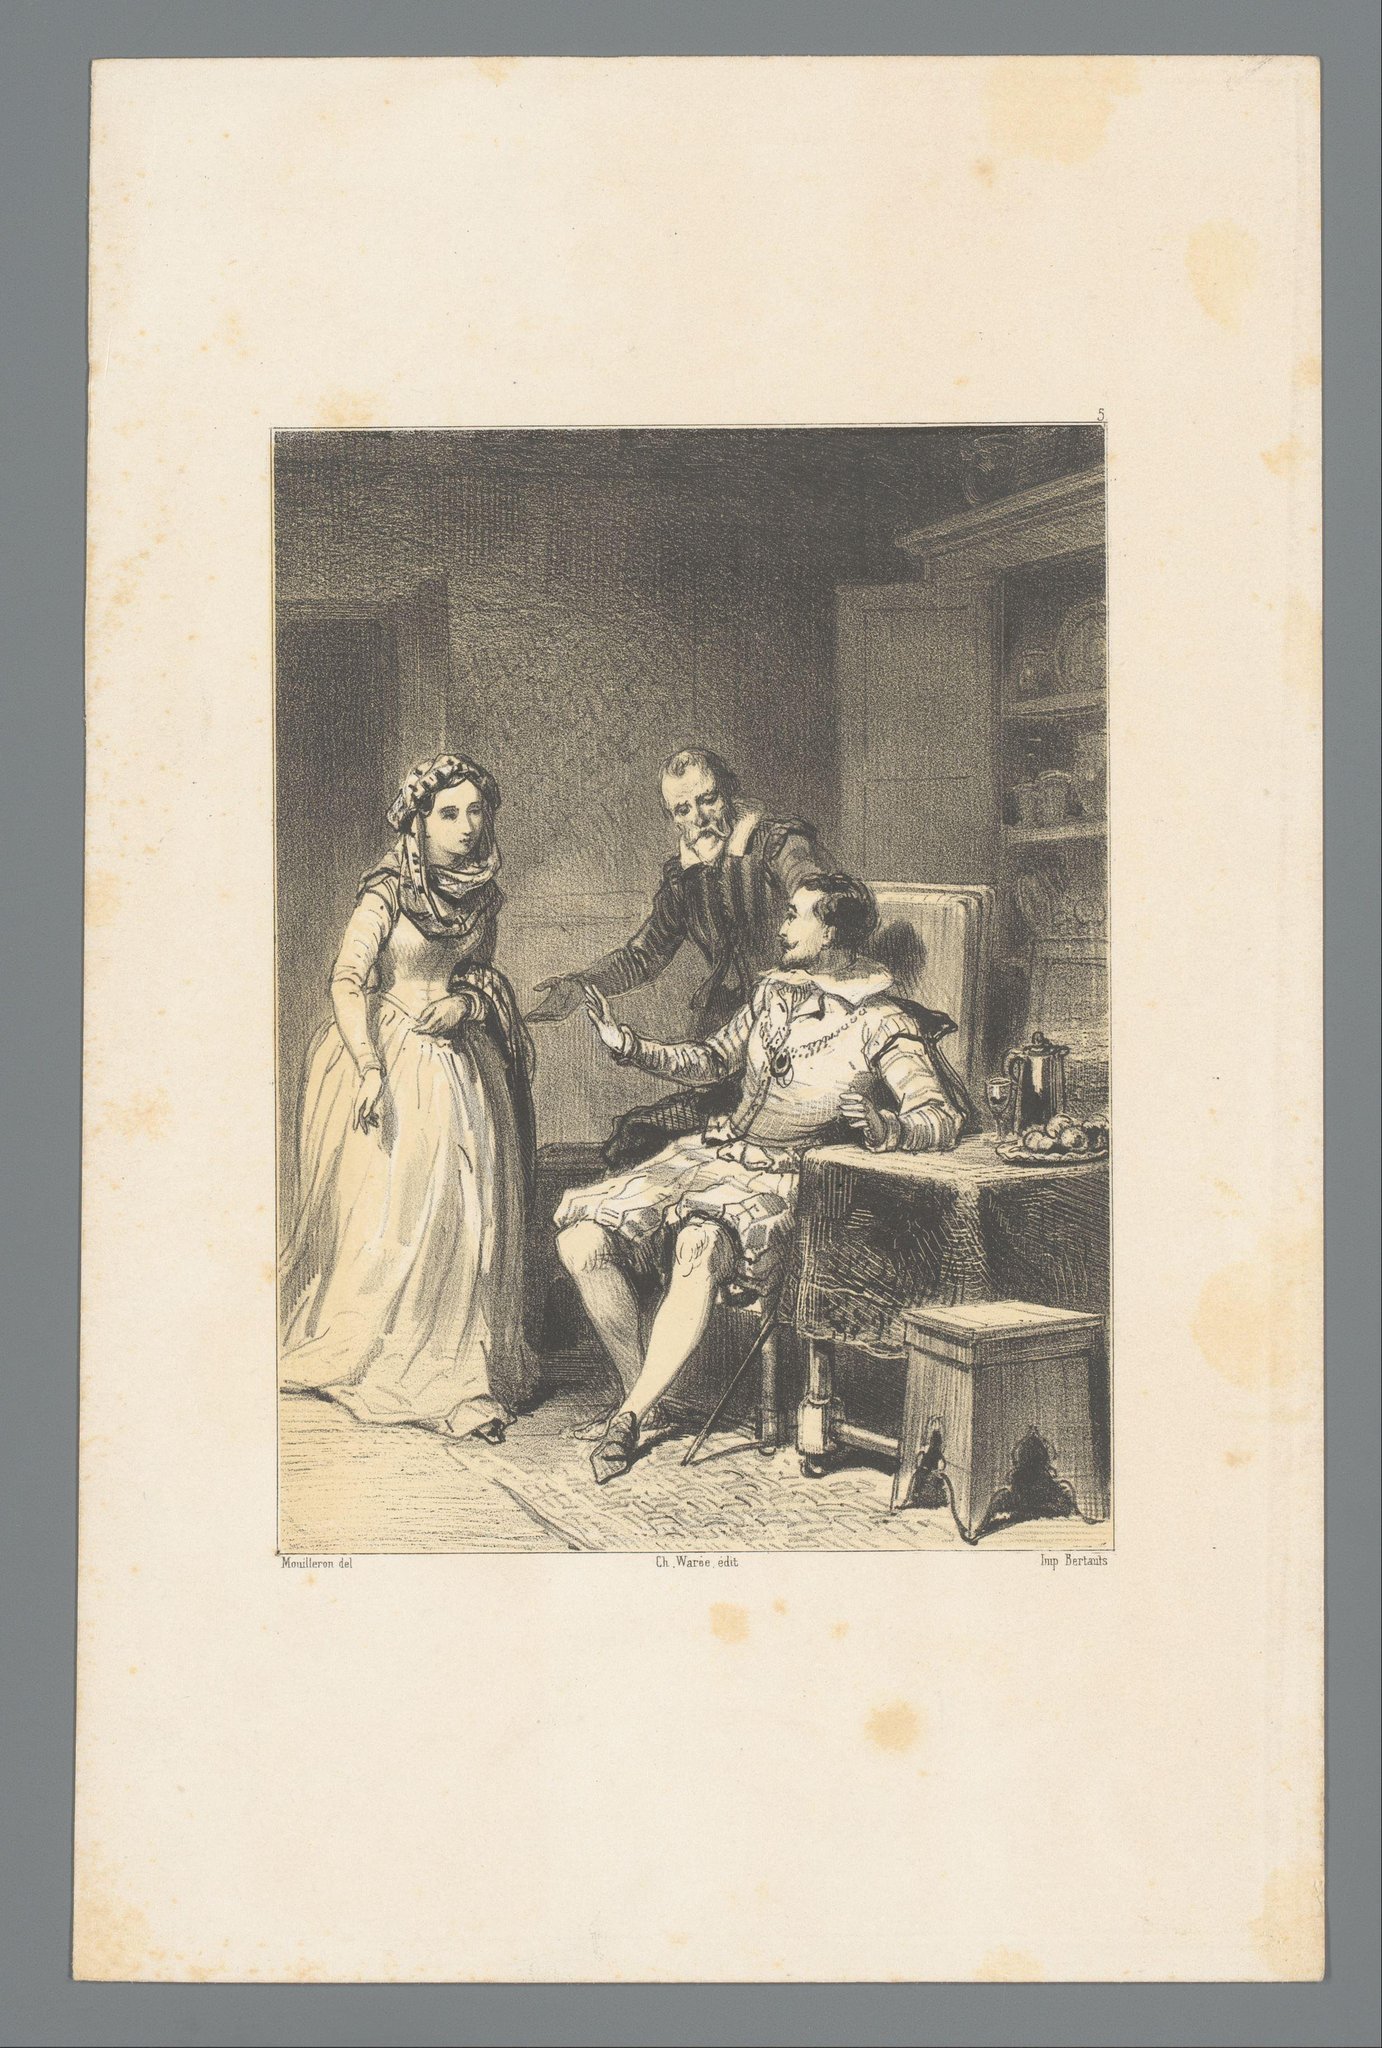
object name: book illustration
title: Zittende man ontvangt vrouw in zijn kamer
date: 1843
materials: paper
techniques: tone lithography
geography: paris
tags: adult man (+ sitting), adult woman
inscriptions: collector's mark: Lugt 964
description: Prent verschenen in: Leprince de Baumont, Jeanne-Marie en Eugénie Foa. Le magasin des enfants. Parijs: Charles Warée, 1843.